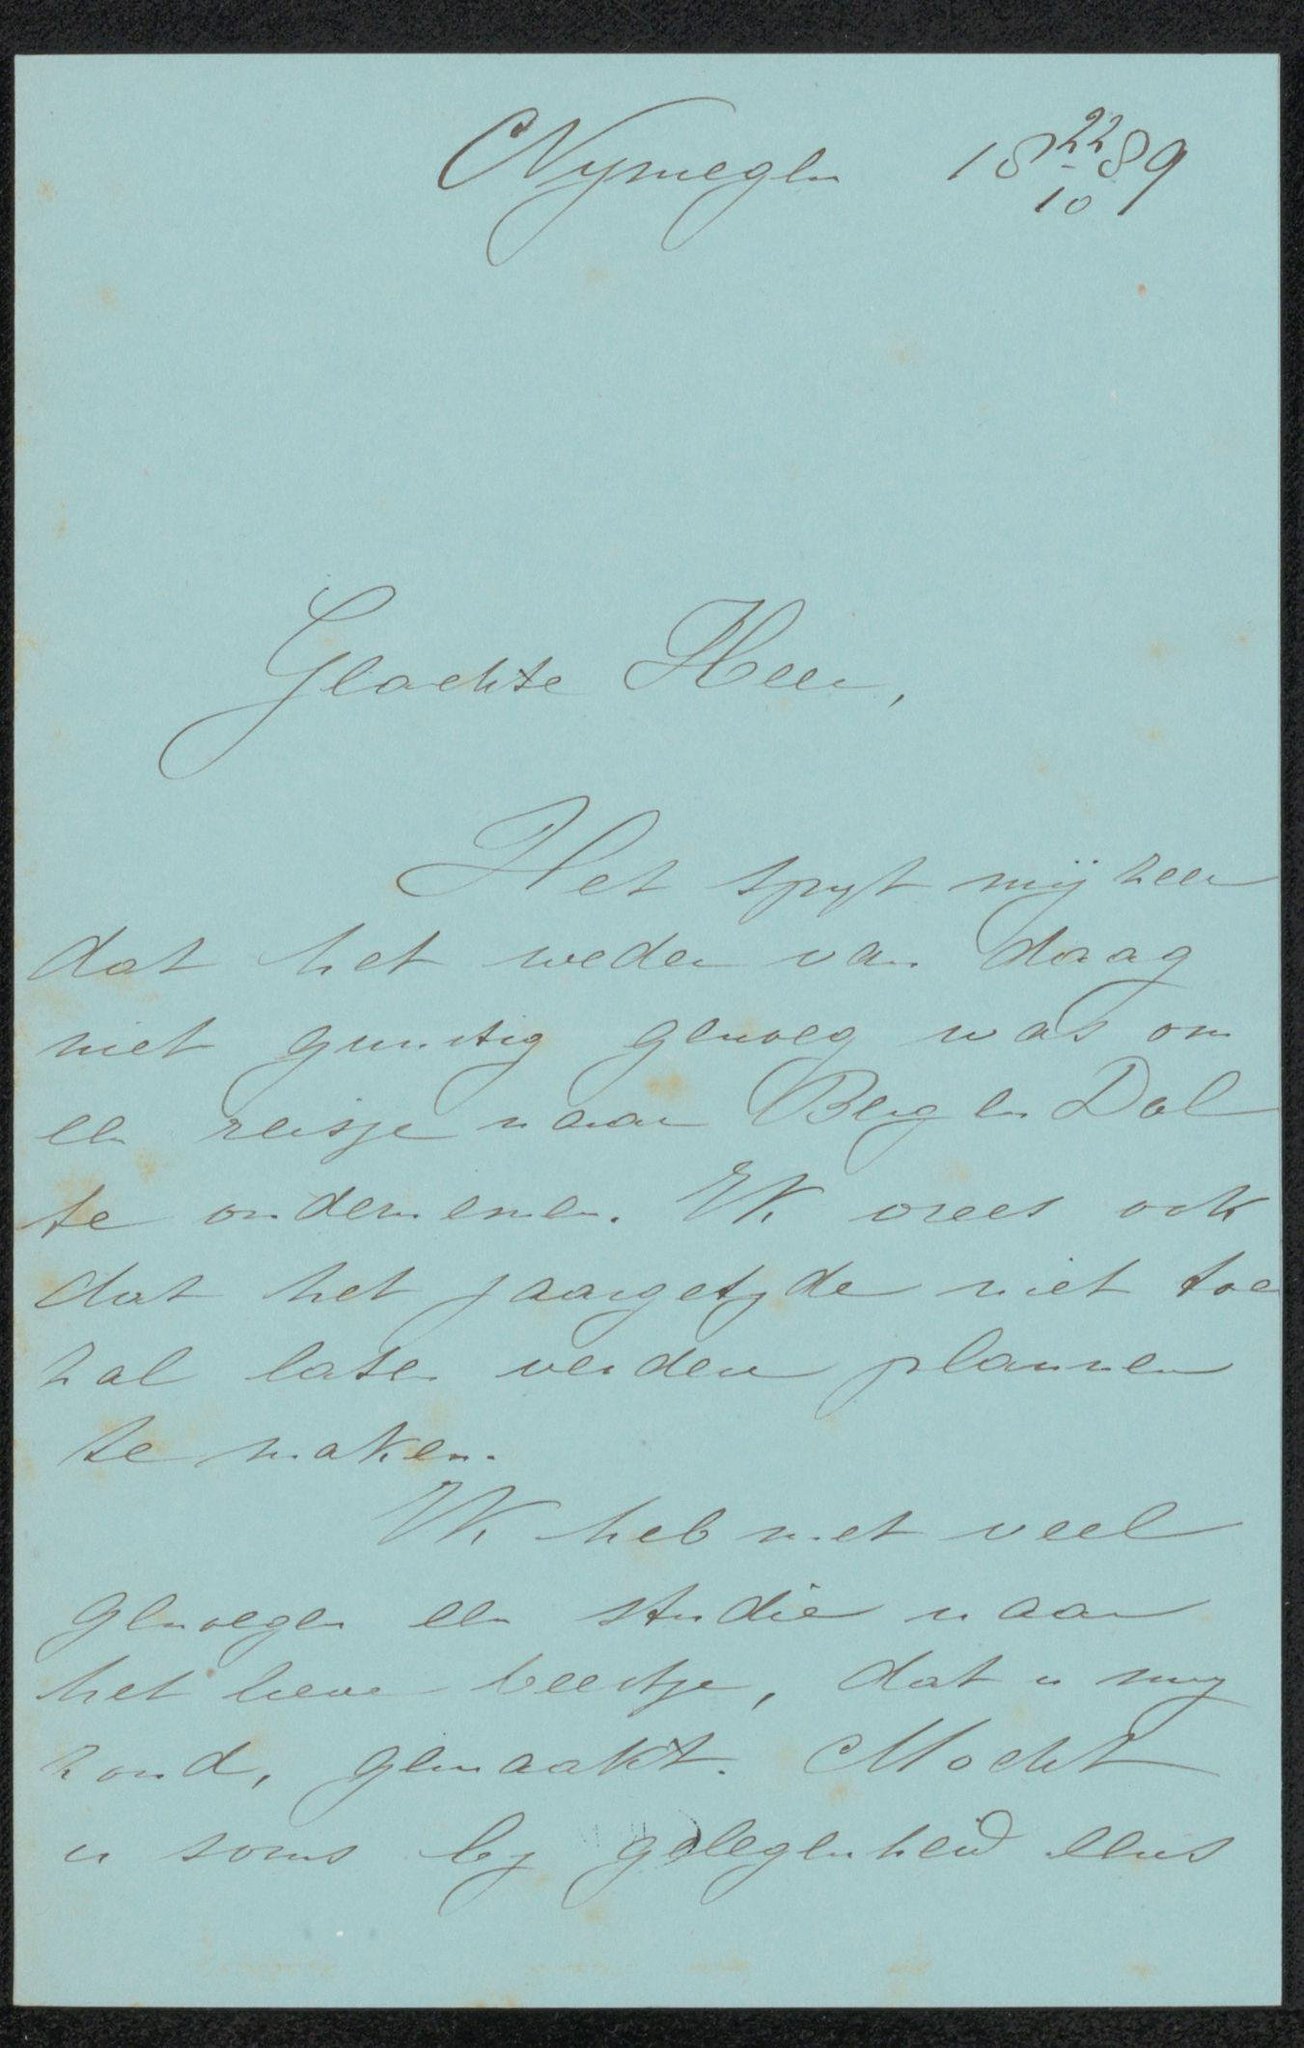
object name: letter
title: Brief aan Ary Johannes Lamme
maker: cornelia schouten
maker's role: painter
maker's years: 1849-1929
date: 1889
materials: ink, paper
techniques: pen, writing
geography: nijmegen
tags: draughtsman, ary johannes lamme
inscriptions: collector's mark: Lugt 2228